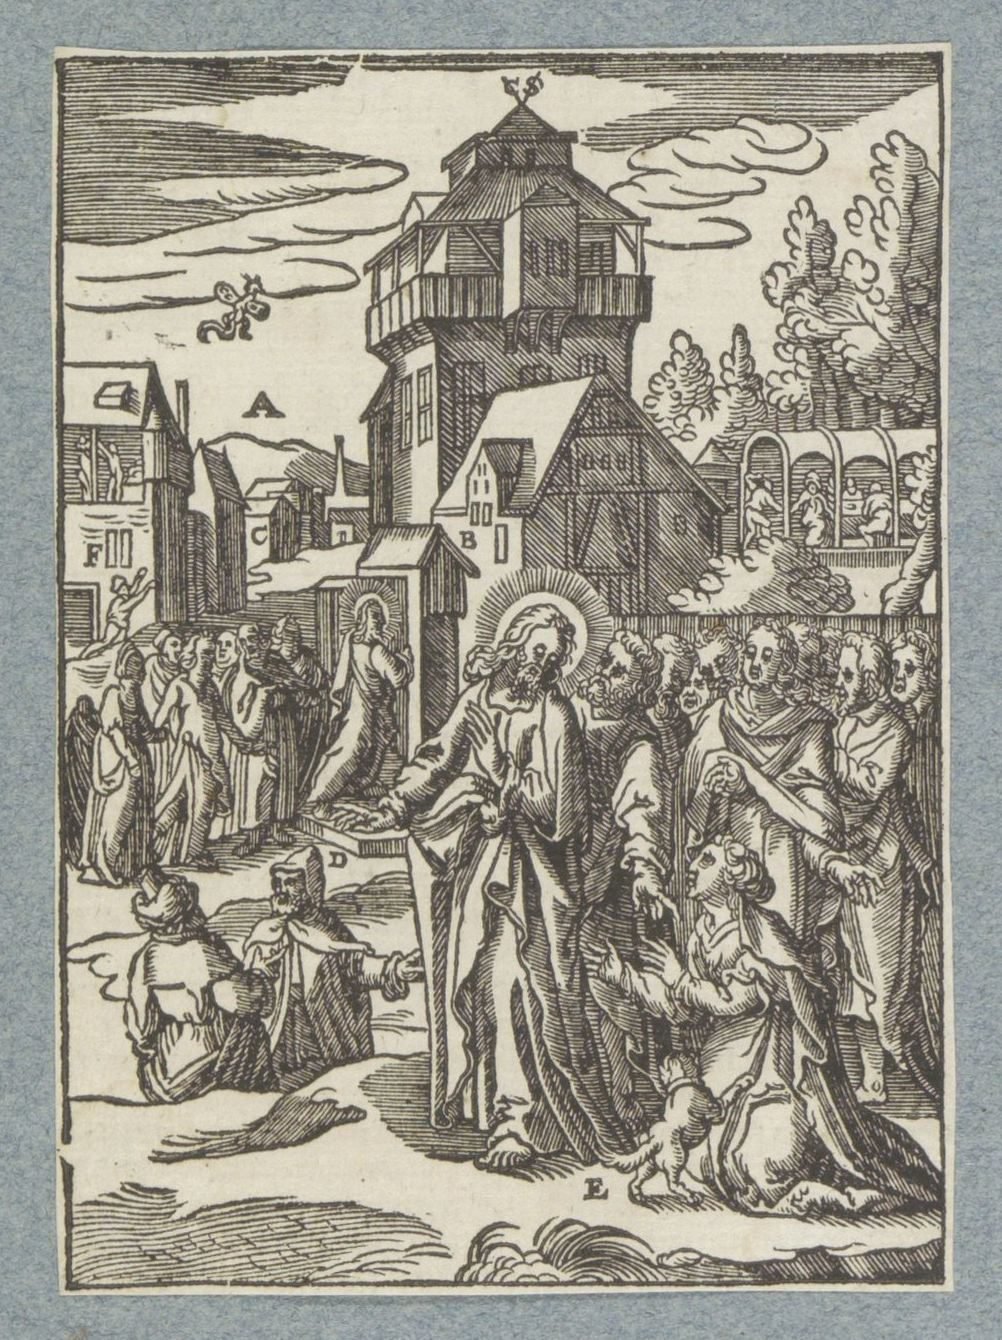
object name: book illustration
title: Christus en de vrouw uit Kanaän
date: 1629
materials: paper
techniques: letterpress printing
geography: amsterdam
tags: a canaanite woman kneels before christ, asking him to heal her daughter; the metaphor of the dogs and bread (matthew 15:21-28; mark 7:24-30)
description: Een Kanaänitische vrouw die Christus eerst naar binnen was gevolgd, werpt zich voor Christus en smeekt hem haar dochter, die door een demon wordt gekweld, te genezen. Zijn leerlingen vragen Christus om de vrouw weg te sturen. In eerste instantie keurt hij de vrouw geen blik waardig, maar nadat hij is overtuigd van haar geloof geneest hij haar dochter en verdwijnt de demon. Bij verschillende elementen uit de voorstelling staan letters. De prent maakt deel uit van een album.